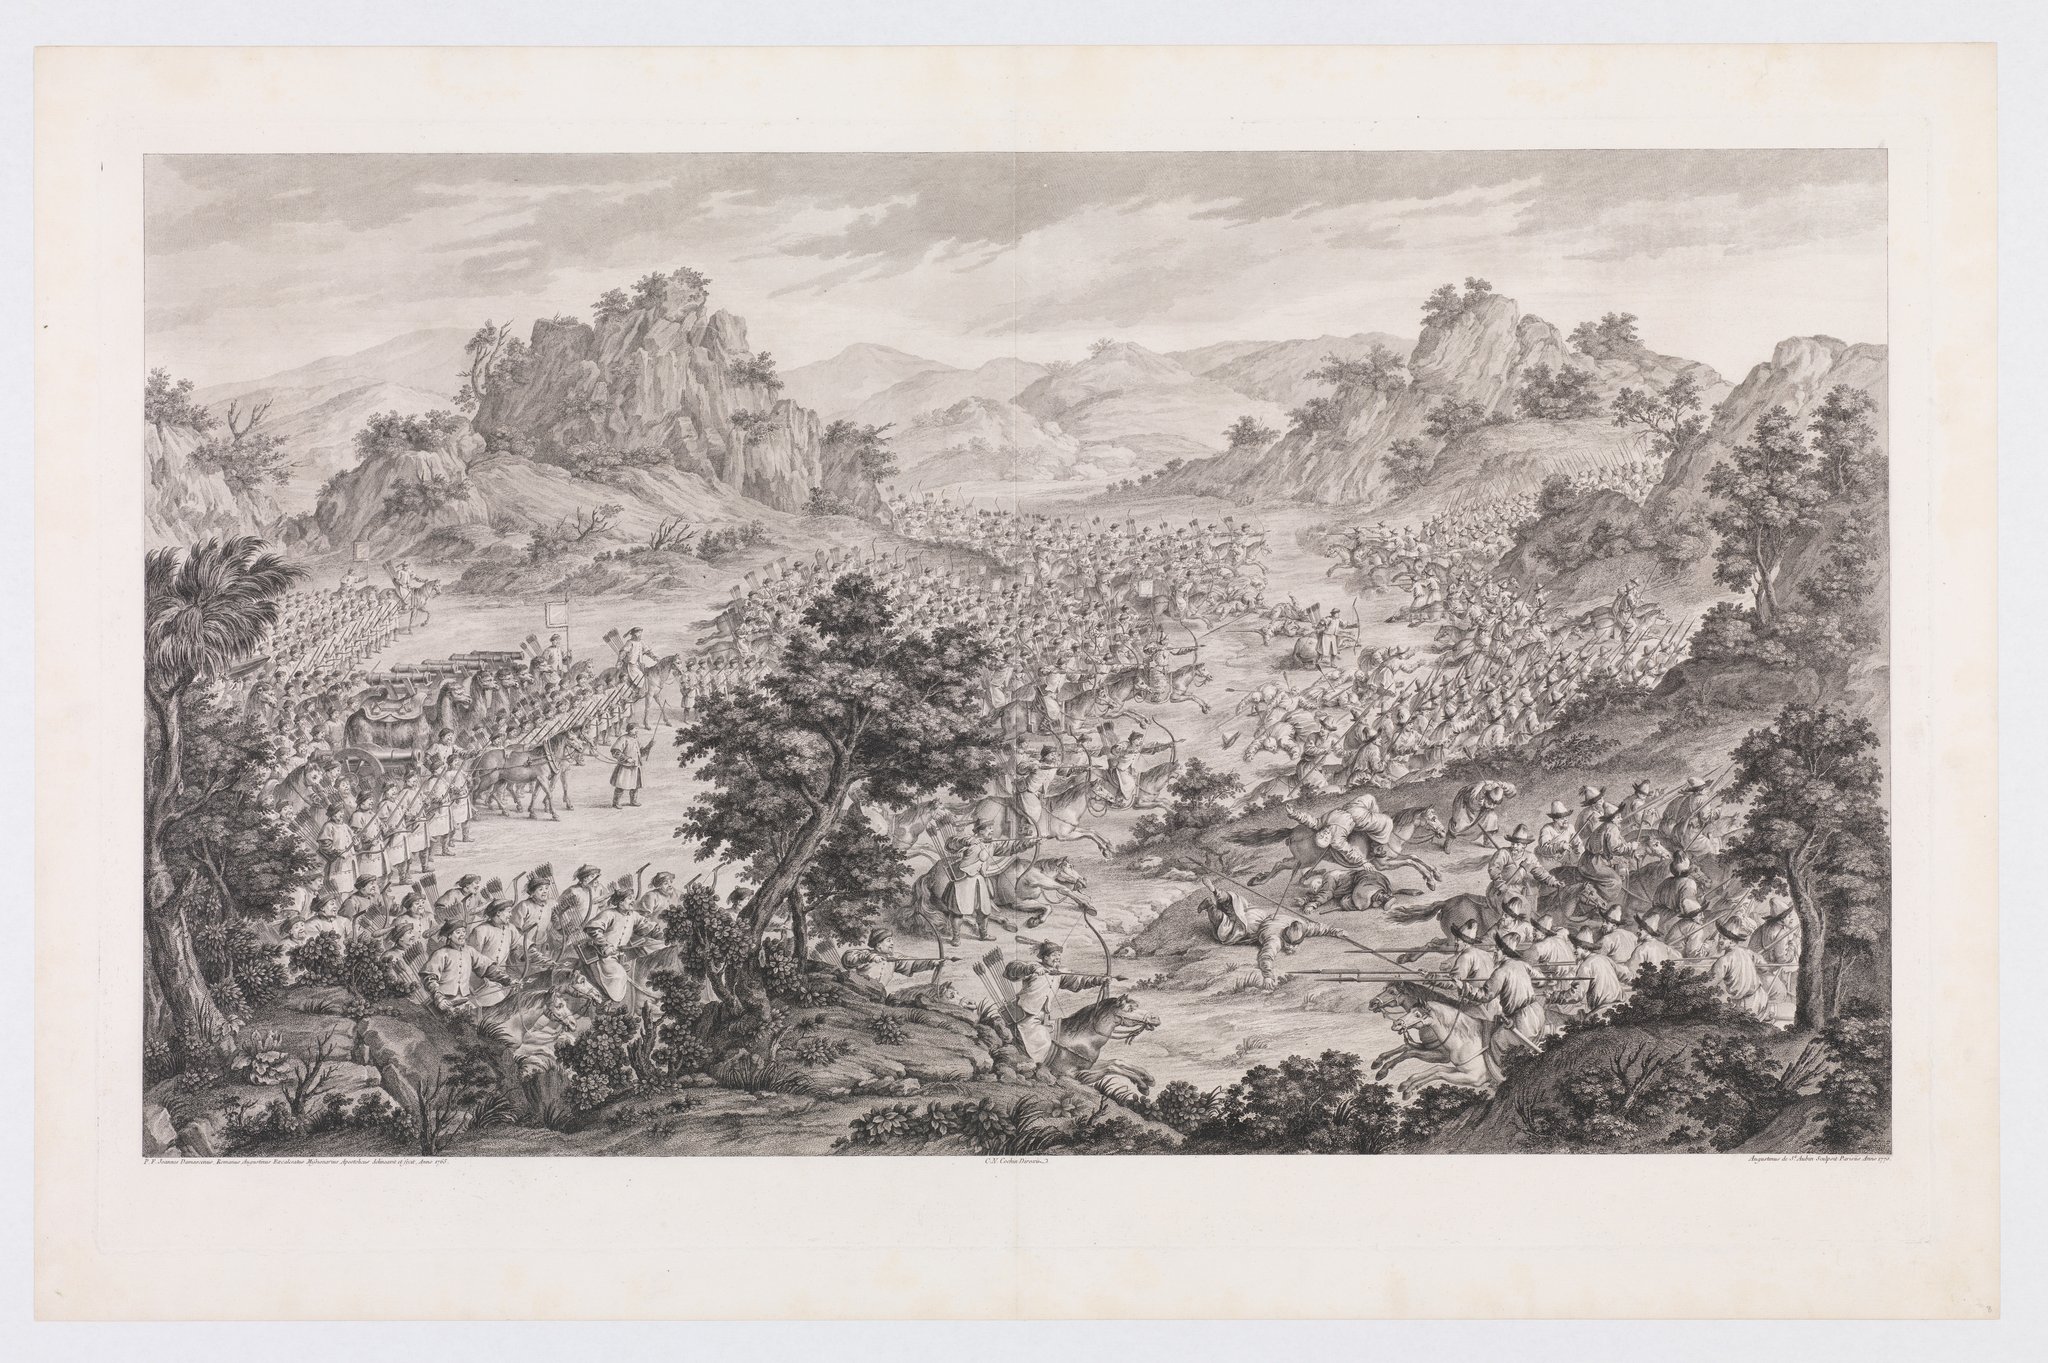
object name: print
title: The Great Victory of Qurnam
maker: augustin de saint-aubin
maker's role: artist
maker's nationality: french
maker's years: 1736-1807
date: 1770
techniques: engraving, etching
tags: battles,soldiers